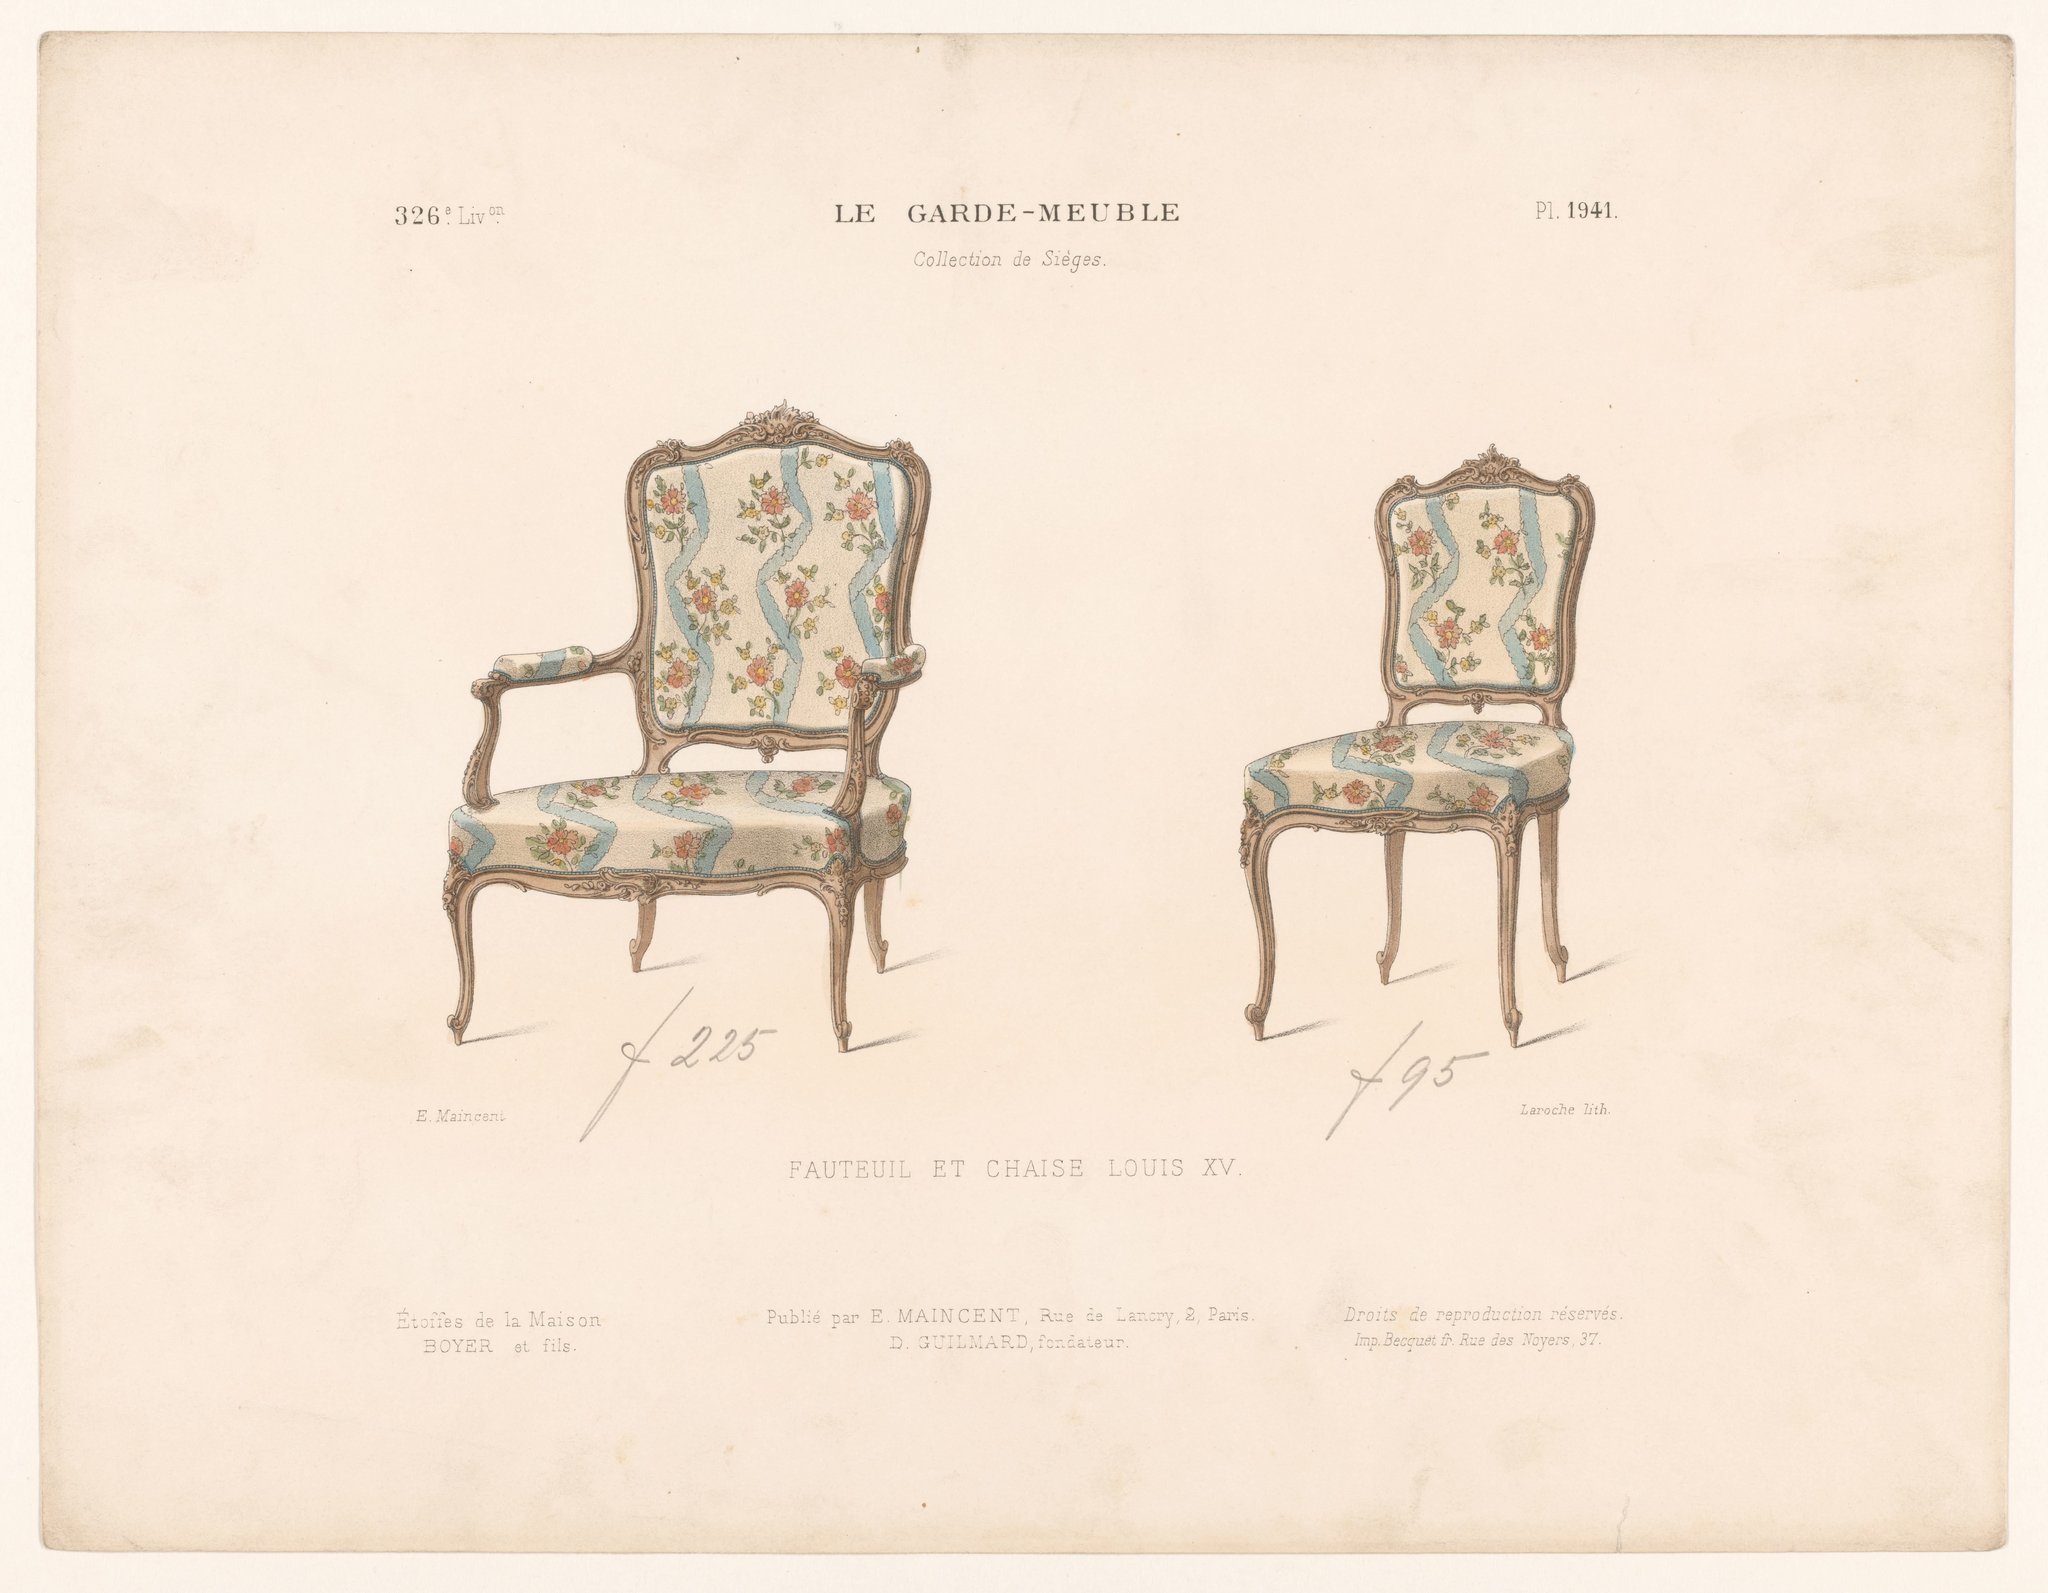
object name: print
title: Fauteuil en stoel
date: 1885-1895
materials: paper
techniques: hand coloring, lithograph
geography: paris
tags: seating furniture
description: Ieder Livraison in de serie Le Garde-Meuble bevat negen platen: drie 'sièges' (zitmeubels), drie 'meubles' (diverse meubels zoals tafels en kasten) en drie 'tentures' (gordijnen en draperieën).